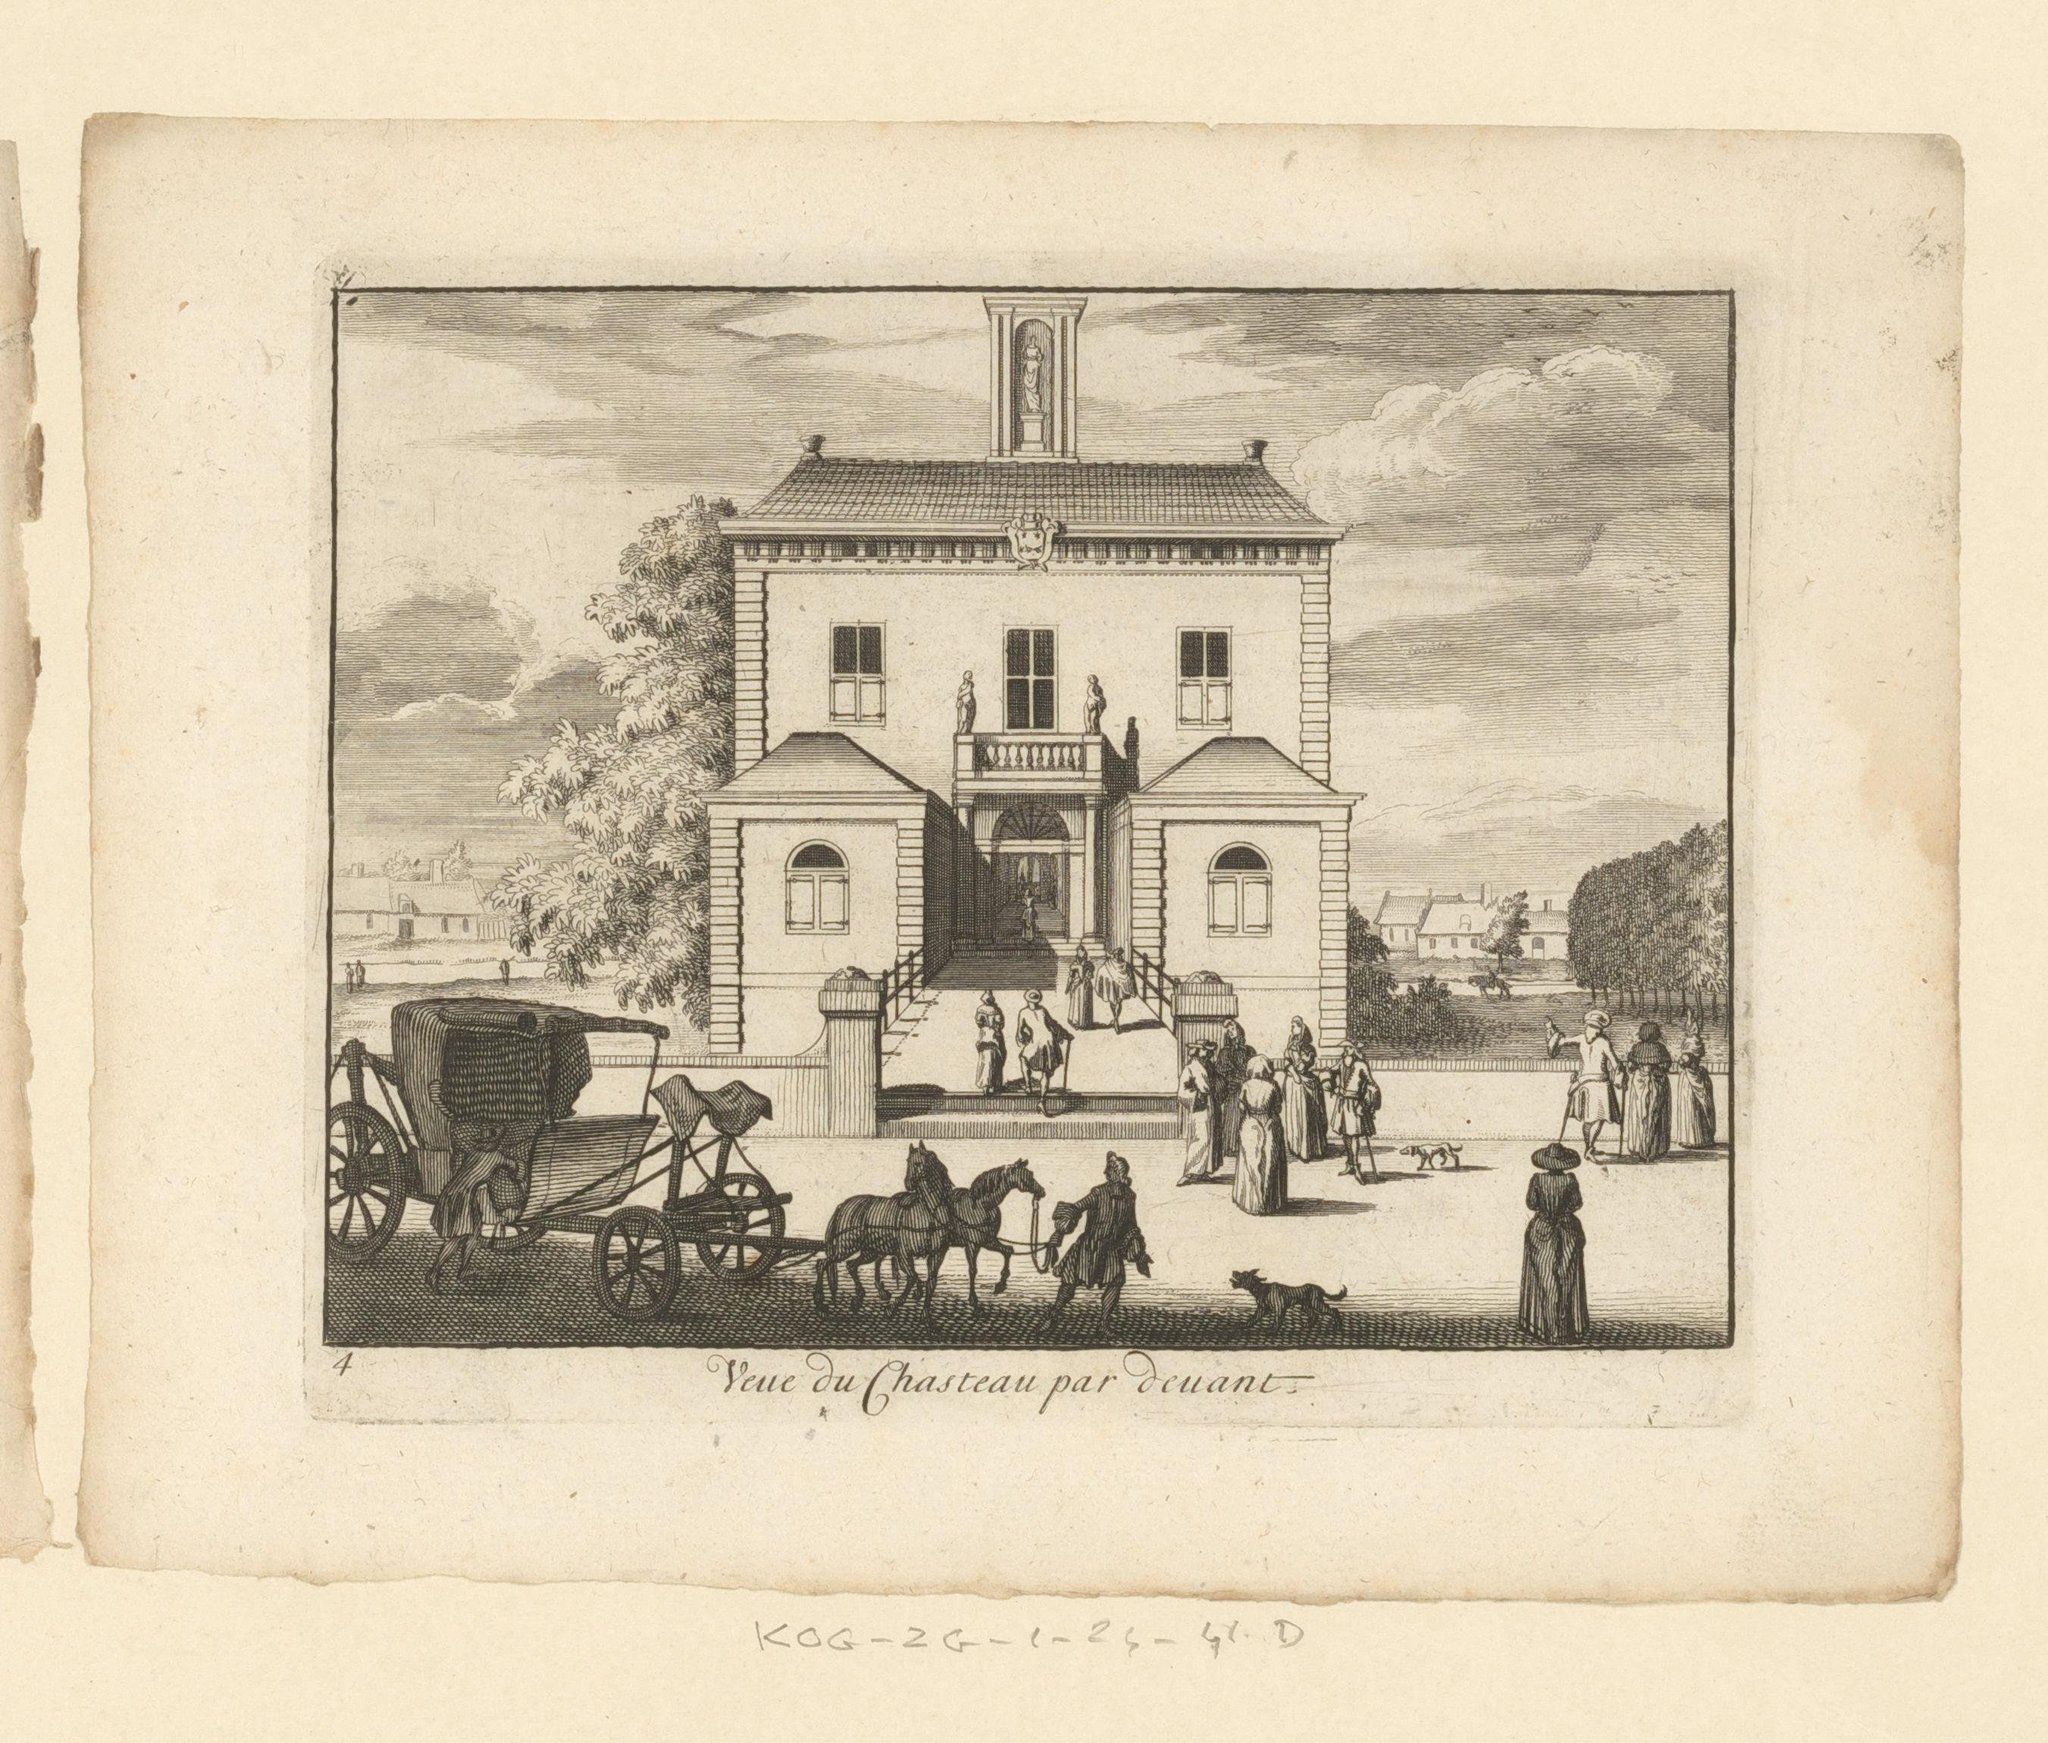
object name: print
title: Gezichten op Gunterstein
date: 1721-1774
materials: paper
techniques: engraving, etching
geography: amsterdam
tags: magdalena poulle, castle, four-wheeled, animal-drawn vehicle, e.g.: cab, carriage, coach, exterior ~ architectural design or model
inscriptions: stamp, collector's mark: Lugt 1641, stamp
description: De voorzijde van Kasteel Gunterstein te Breukelen met op de voorgrond figuren en een stilstaande koets. Linksonder genummerd: 4. Onderwerpsrubrieken binnen de Atlas Zeden en Gewoonten: Zeden en Gewoonten in Engeren Zin, De Woning. Kastelen en buitenplaatsen. Utrecht (vervolg.).